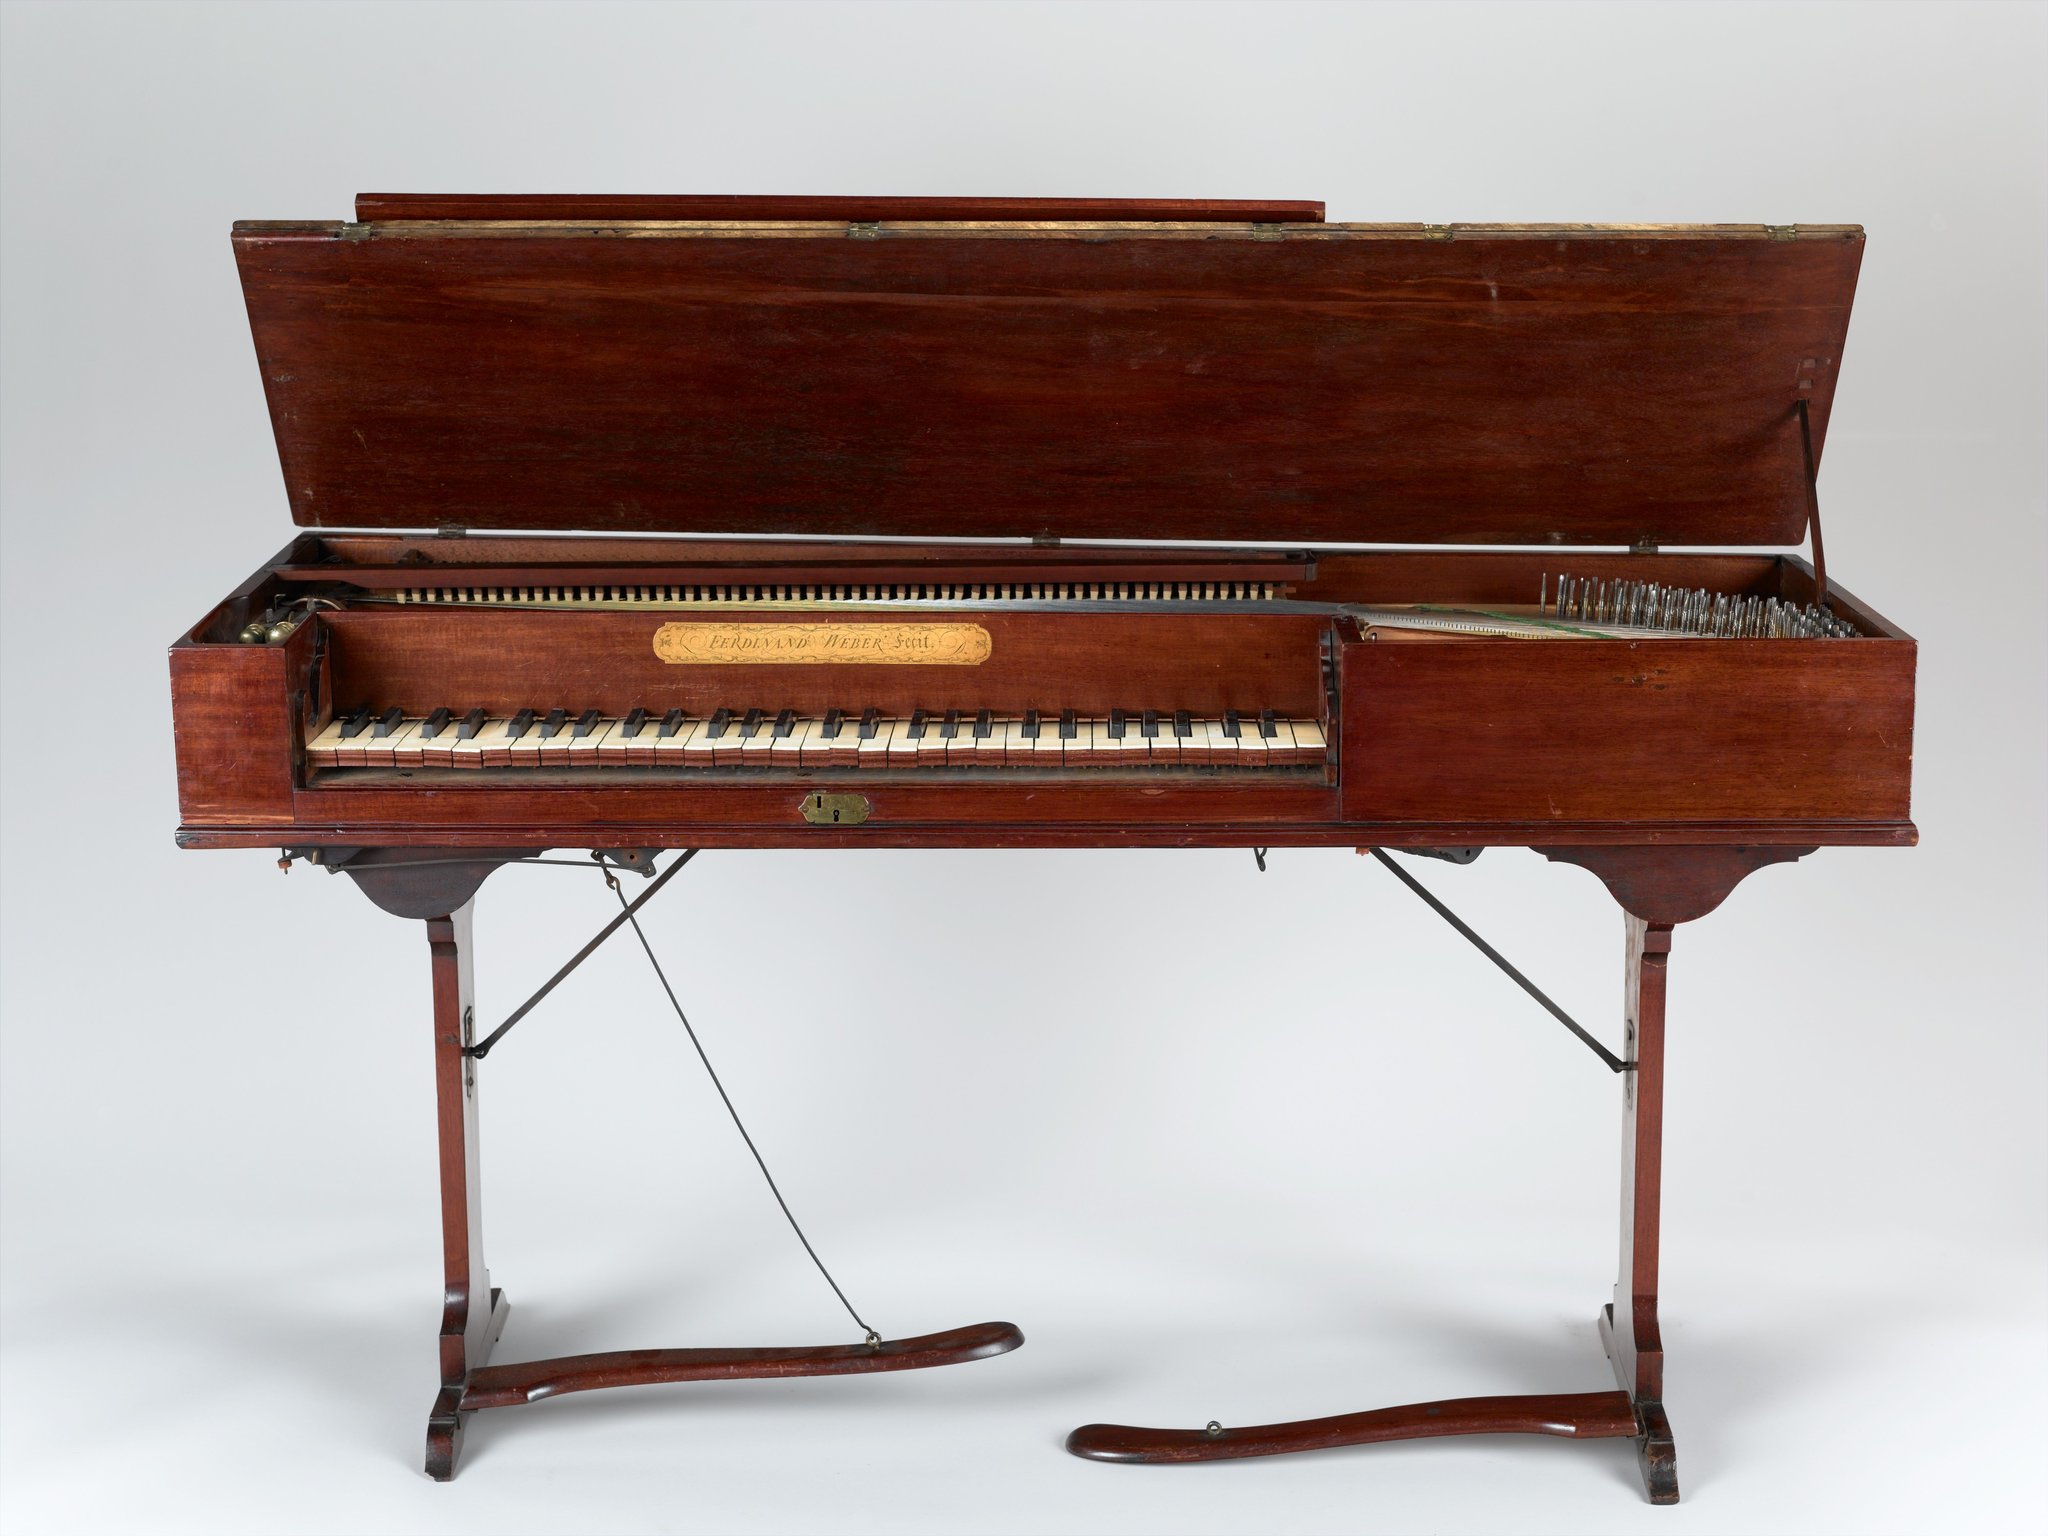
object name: square piano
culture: irish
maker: ferdinand weber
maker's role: maker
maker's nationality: german, active ireland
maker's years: 1715-1784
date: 1772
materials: brass, wood, iron, ivory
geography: ireland